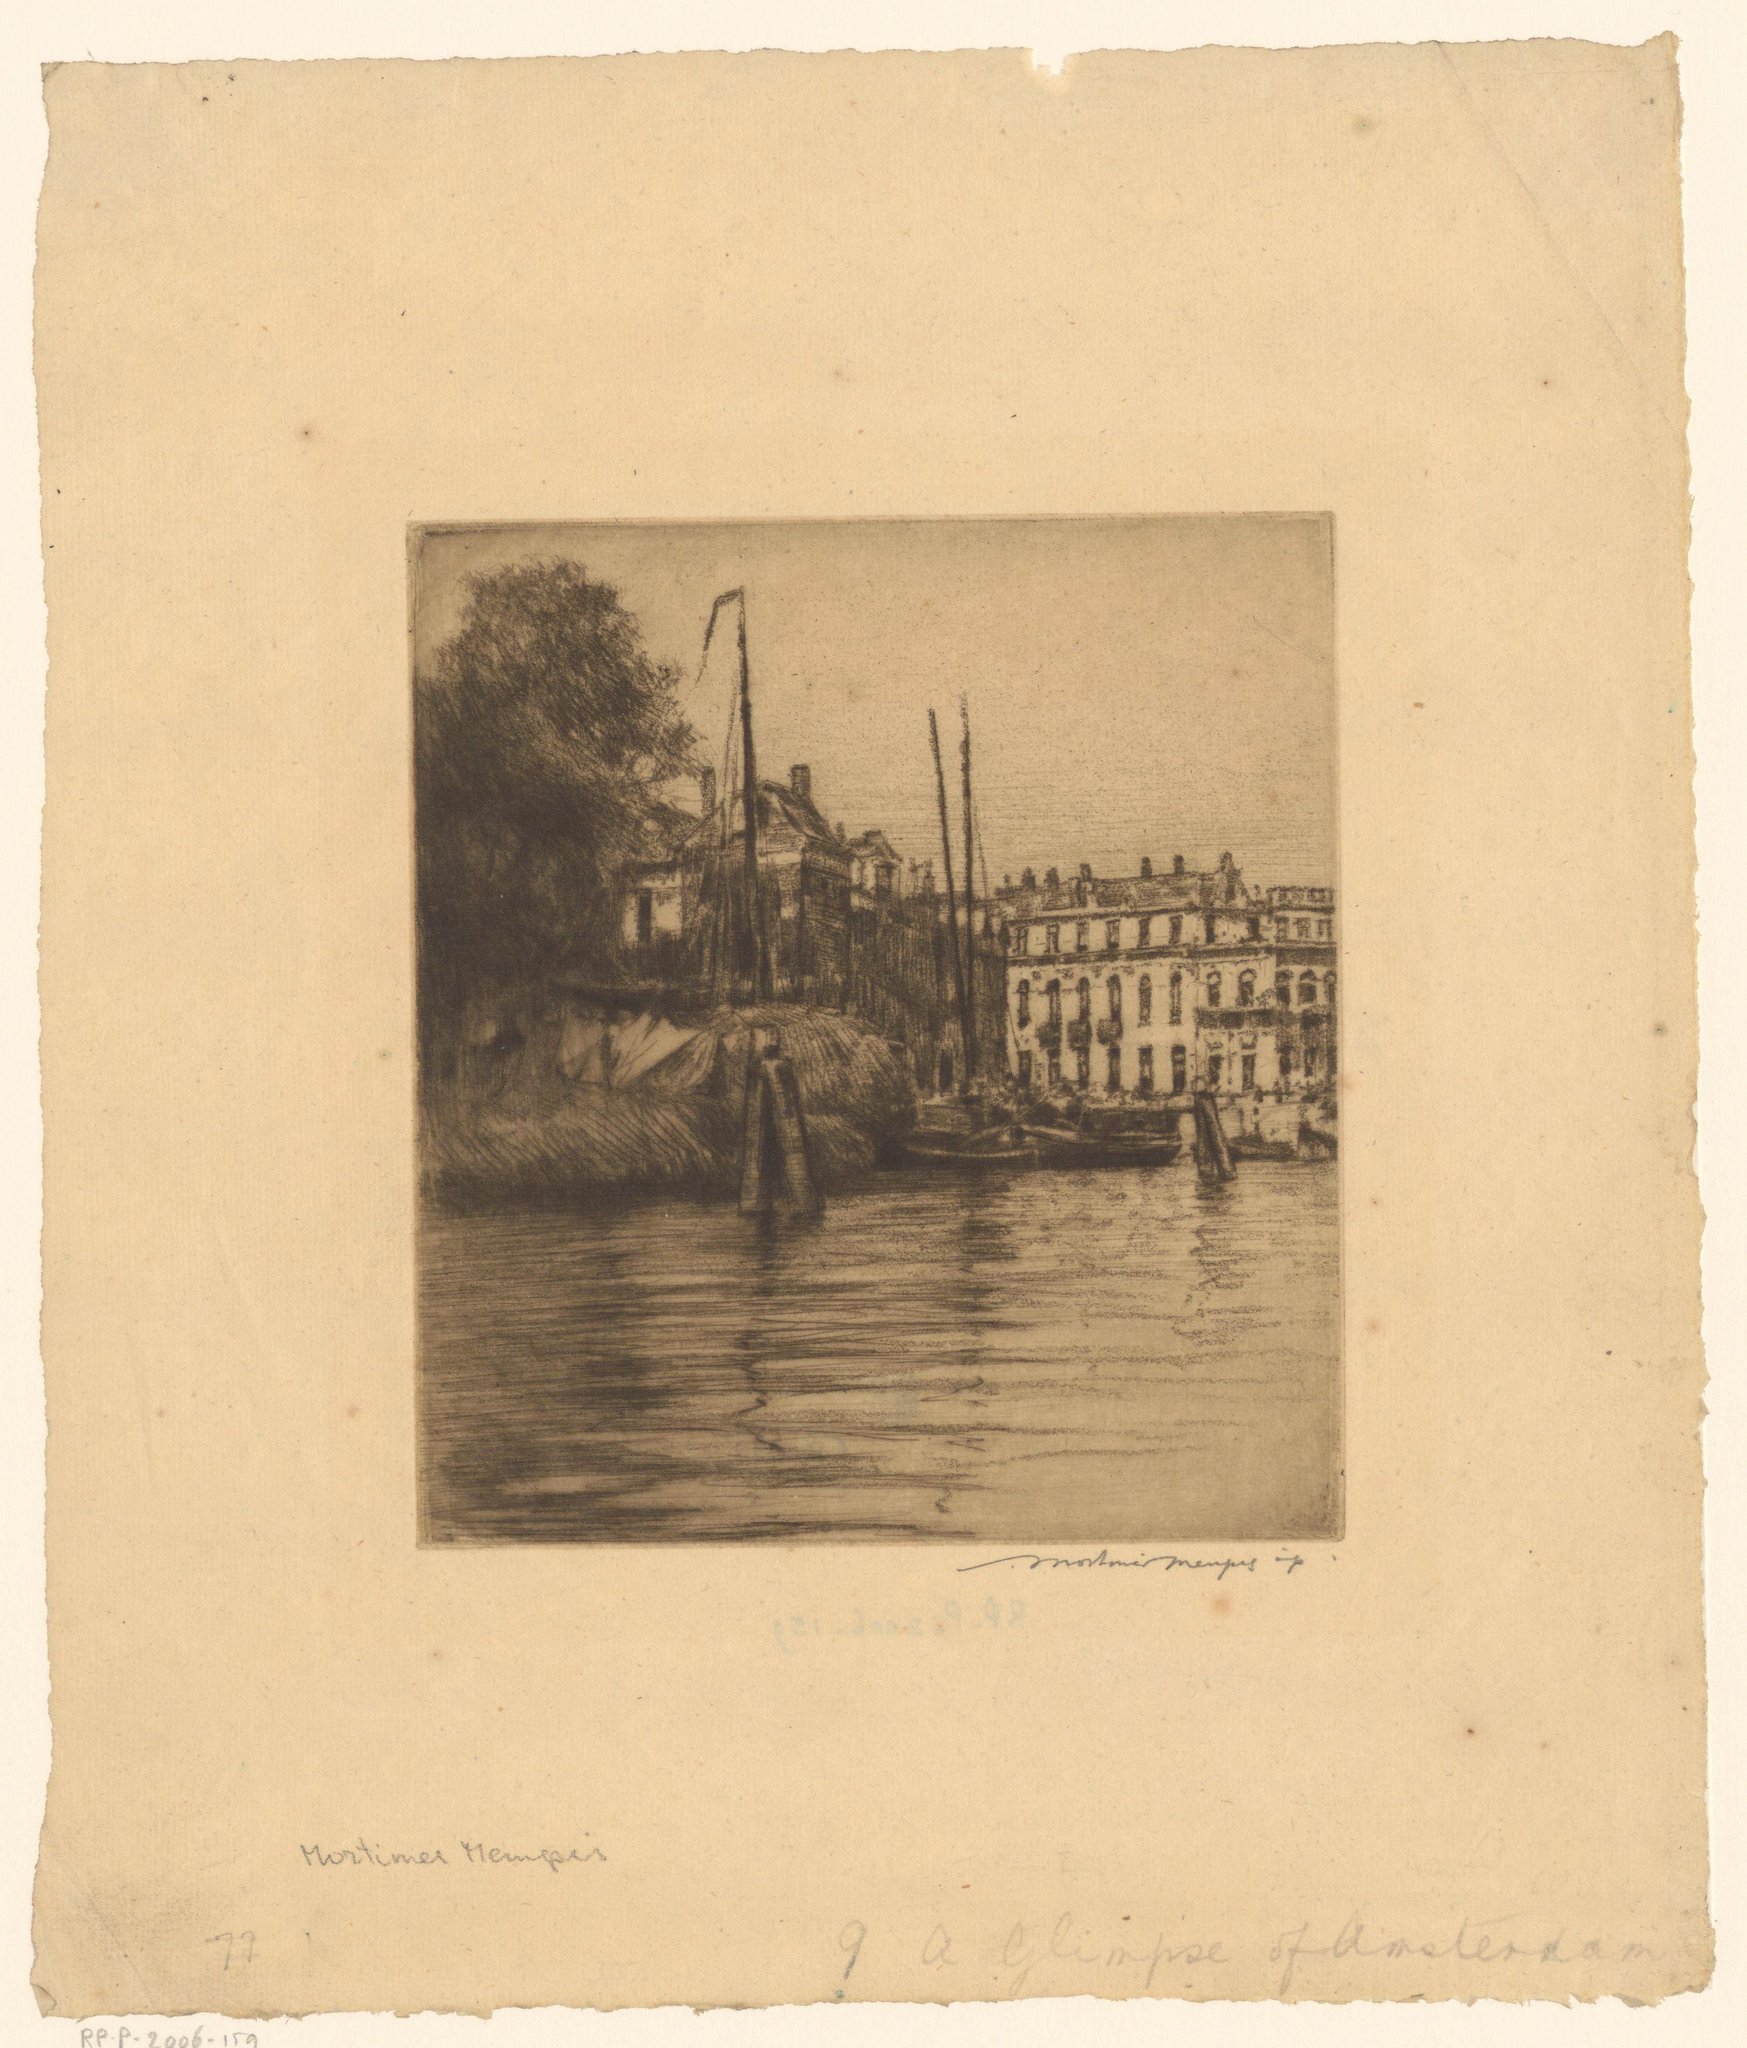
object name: print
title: A Glimpse of Amsterdam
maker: mortimer l. menpes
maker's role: print maker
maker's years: 1855-1938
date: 1889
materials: paper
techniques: drypoint, intaglio, soft ground etching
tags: urban housing, sailing-ship, sailing-boat, canals, waters (in city), amsterdam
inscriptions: signature: ‘Mortimer Menpes’, collector's mark: Lugt 2228, title: ‘9 A Glimpse of Amsterdam’, collector's mark: Lugt 2760